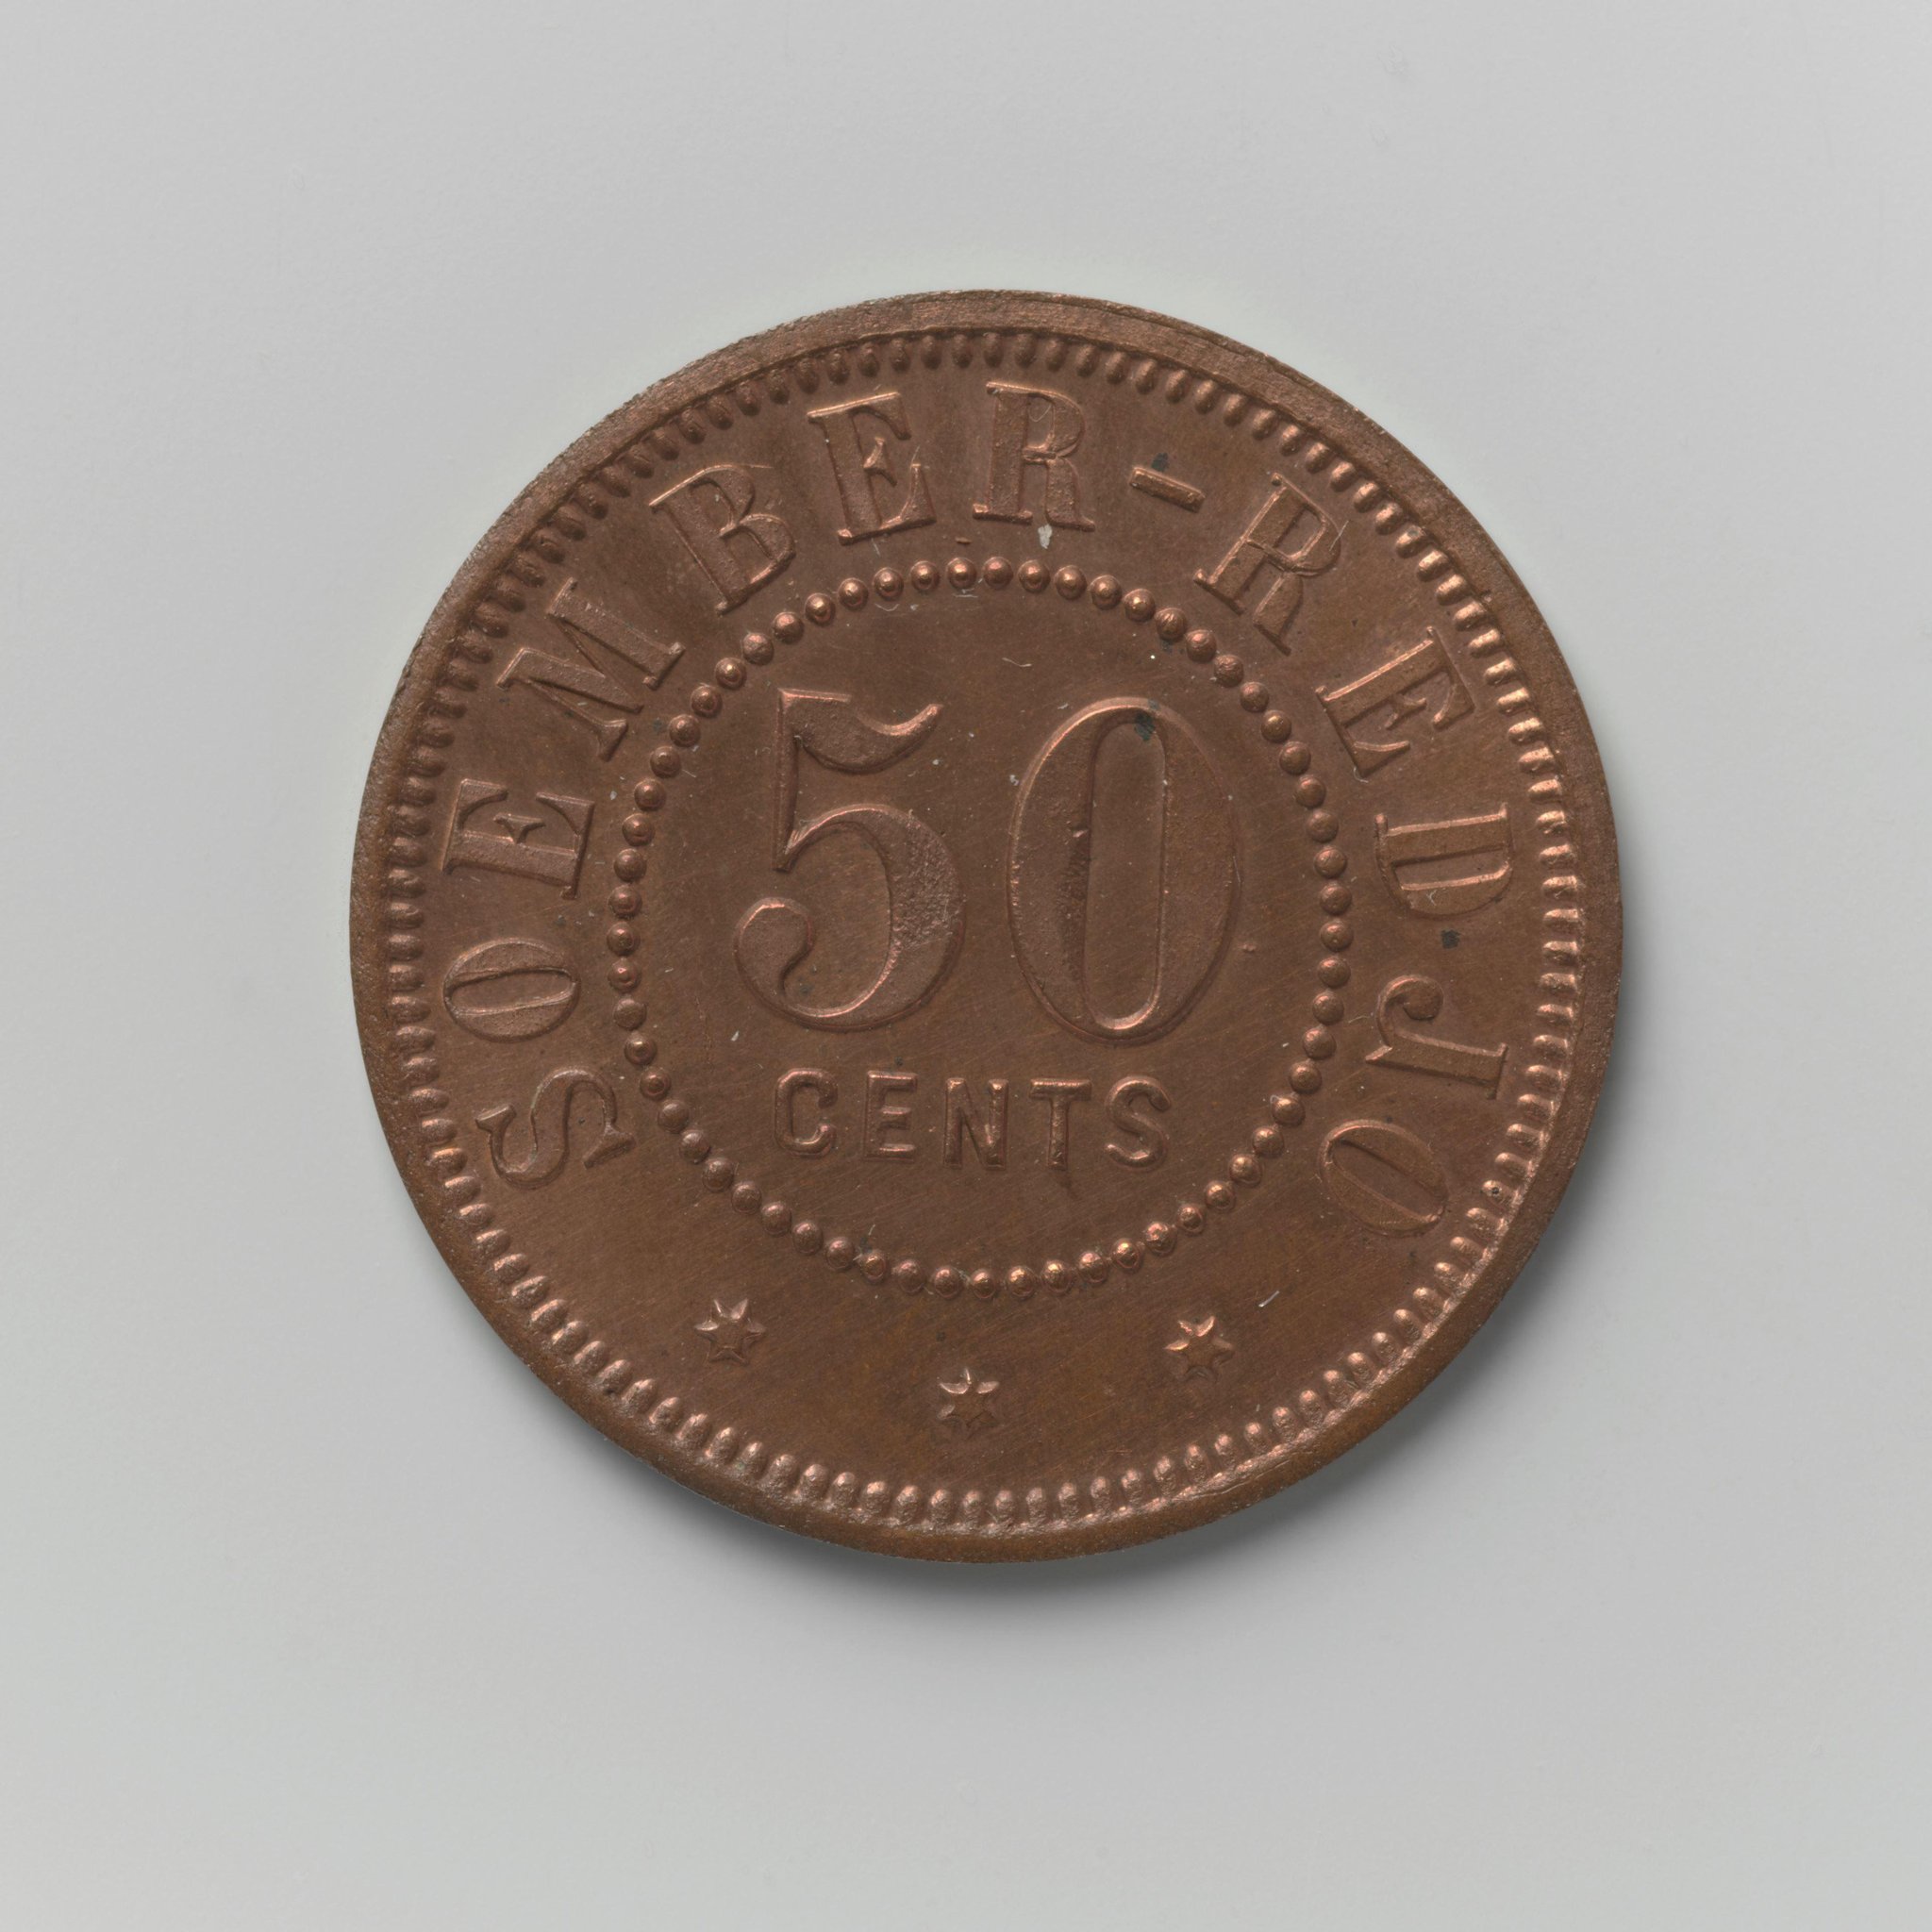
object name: bar money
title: Plantage Soember Boeren, 50 cents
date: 1875-1925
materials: copper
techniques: striking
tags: plantage soember-redjo, passoeroean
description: Koperen partuculiere munt. Plantage-geld. Voorzijde: in twee regels waarde-aanduiding. In omschrift aanduiding van de plantage. Keerzijde: in twee regels waarde-aanduiding. Gladde rand.